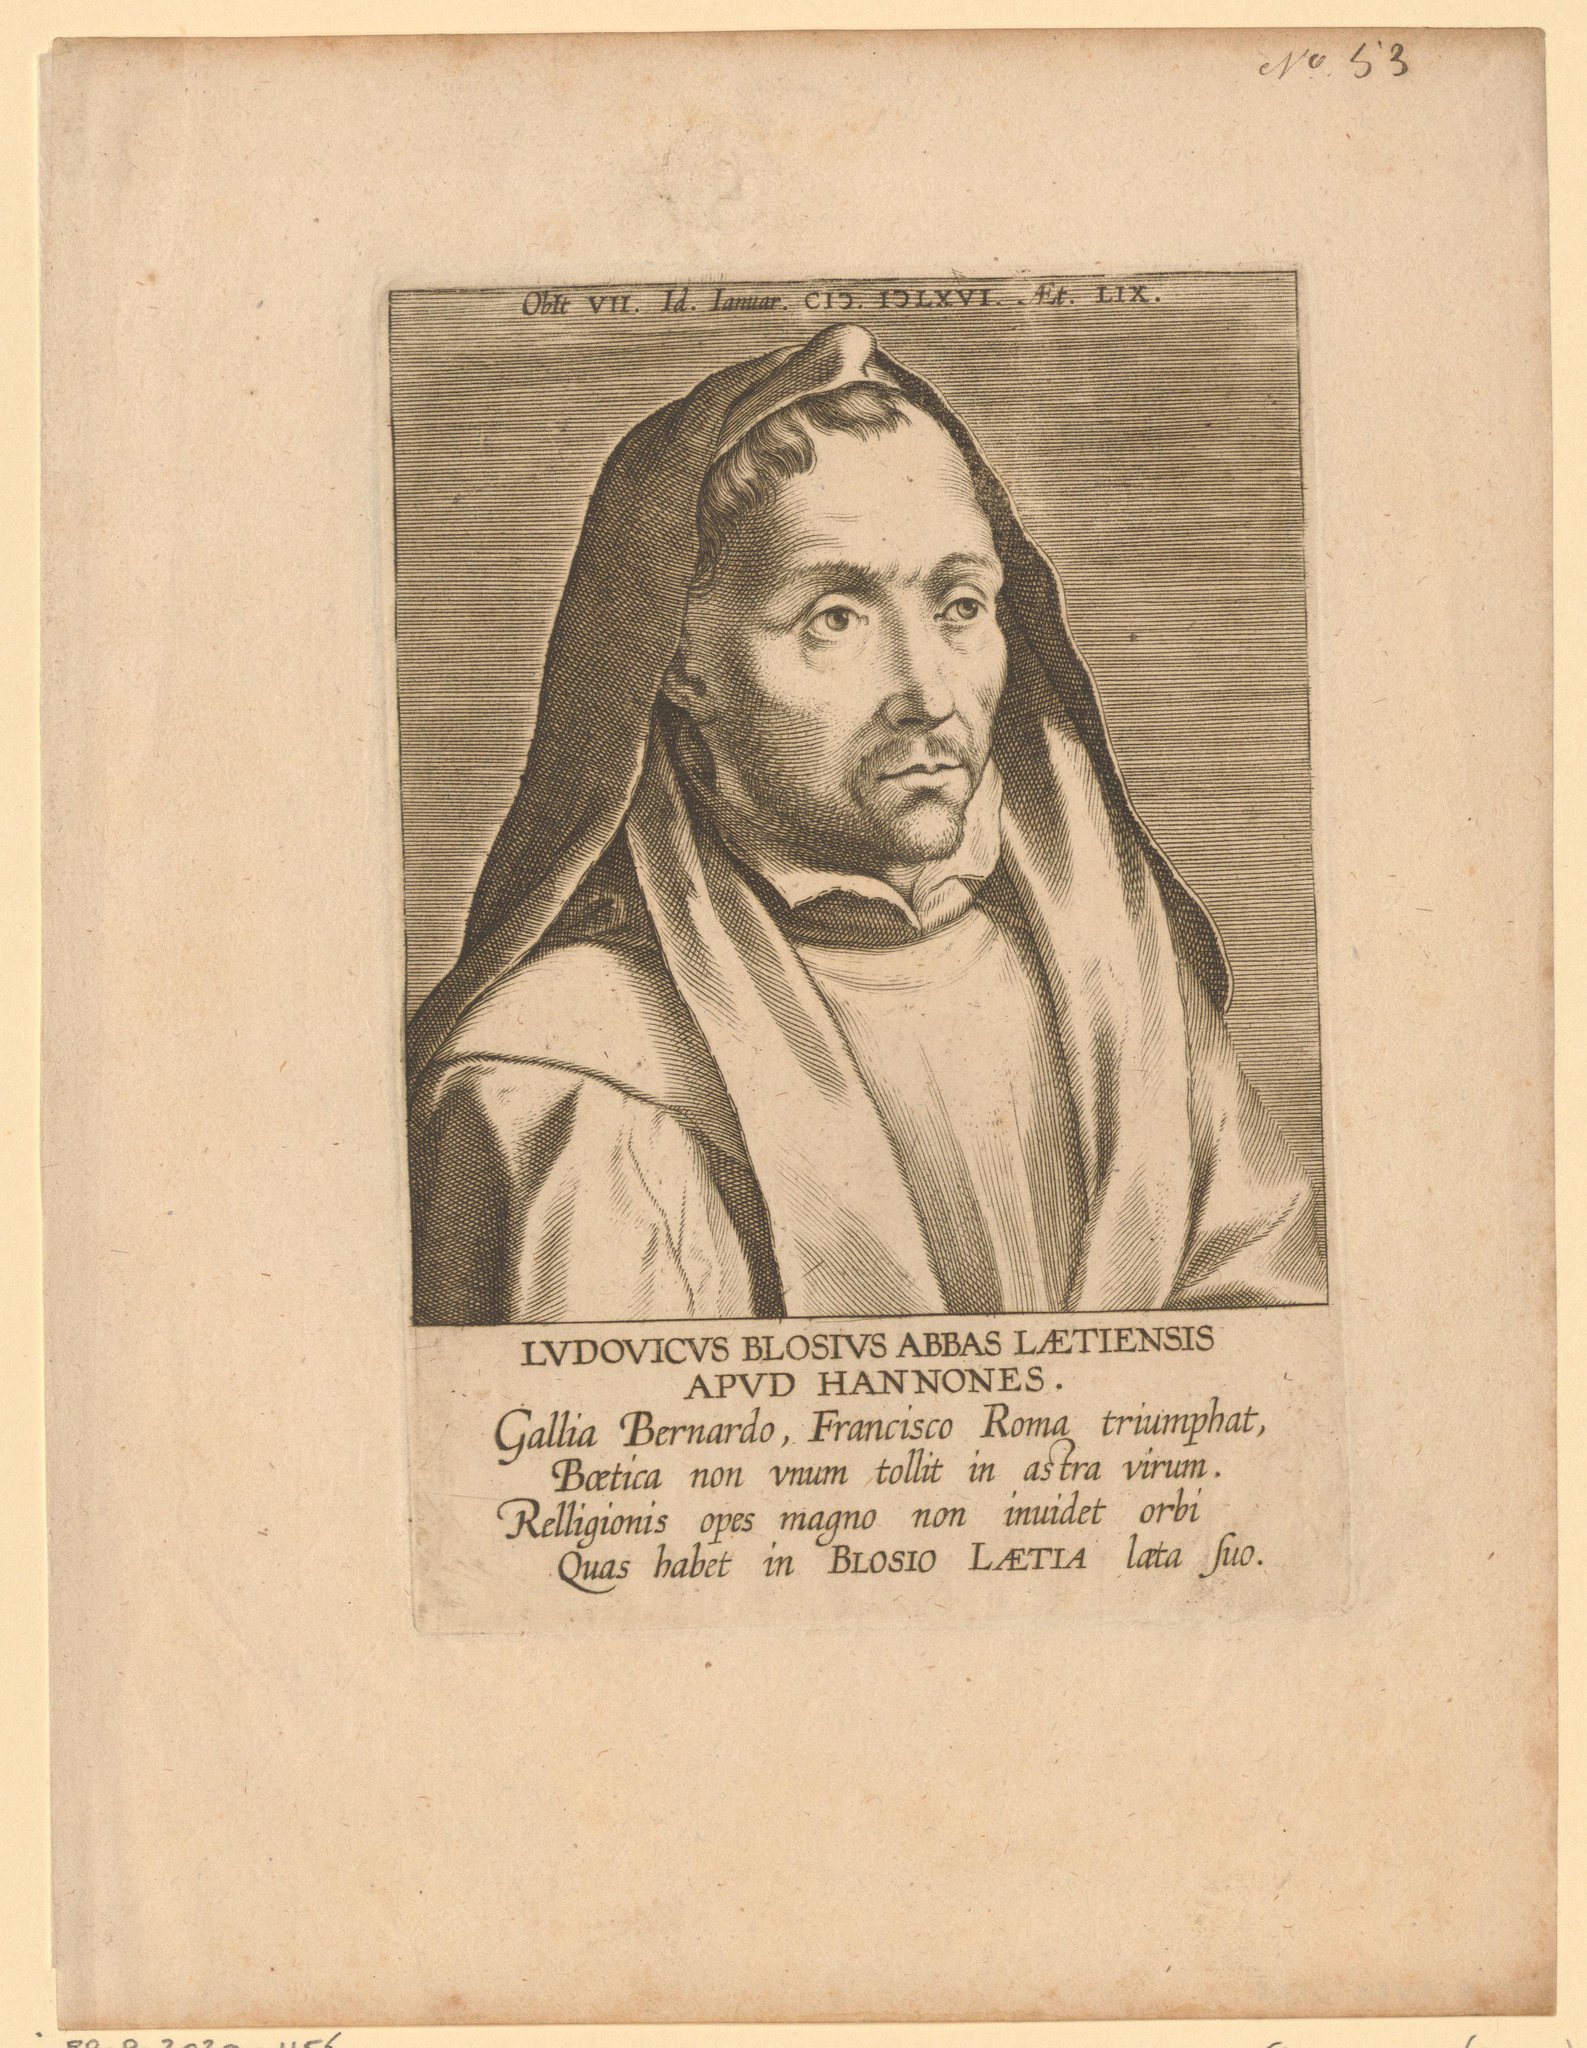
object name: print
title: Portret van Louis de Blois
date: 1604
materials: paper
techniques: engraving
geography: brussels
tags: theologian, historical persons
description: Eerste staat van de prent verschenen in: Illustrium Galliae Belgicae scriptorum icones et elogi. Antwerpen: Philips Galle, 1604. Deze staat van de prent verschenen in: Foppens, Jean François. Bibliotheca Belgica. Brussel: Pierre Foppens, 1739.